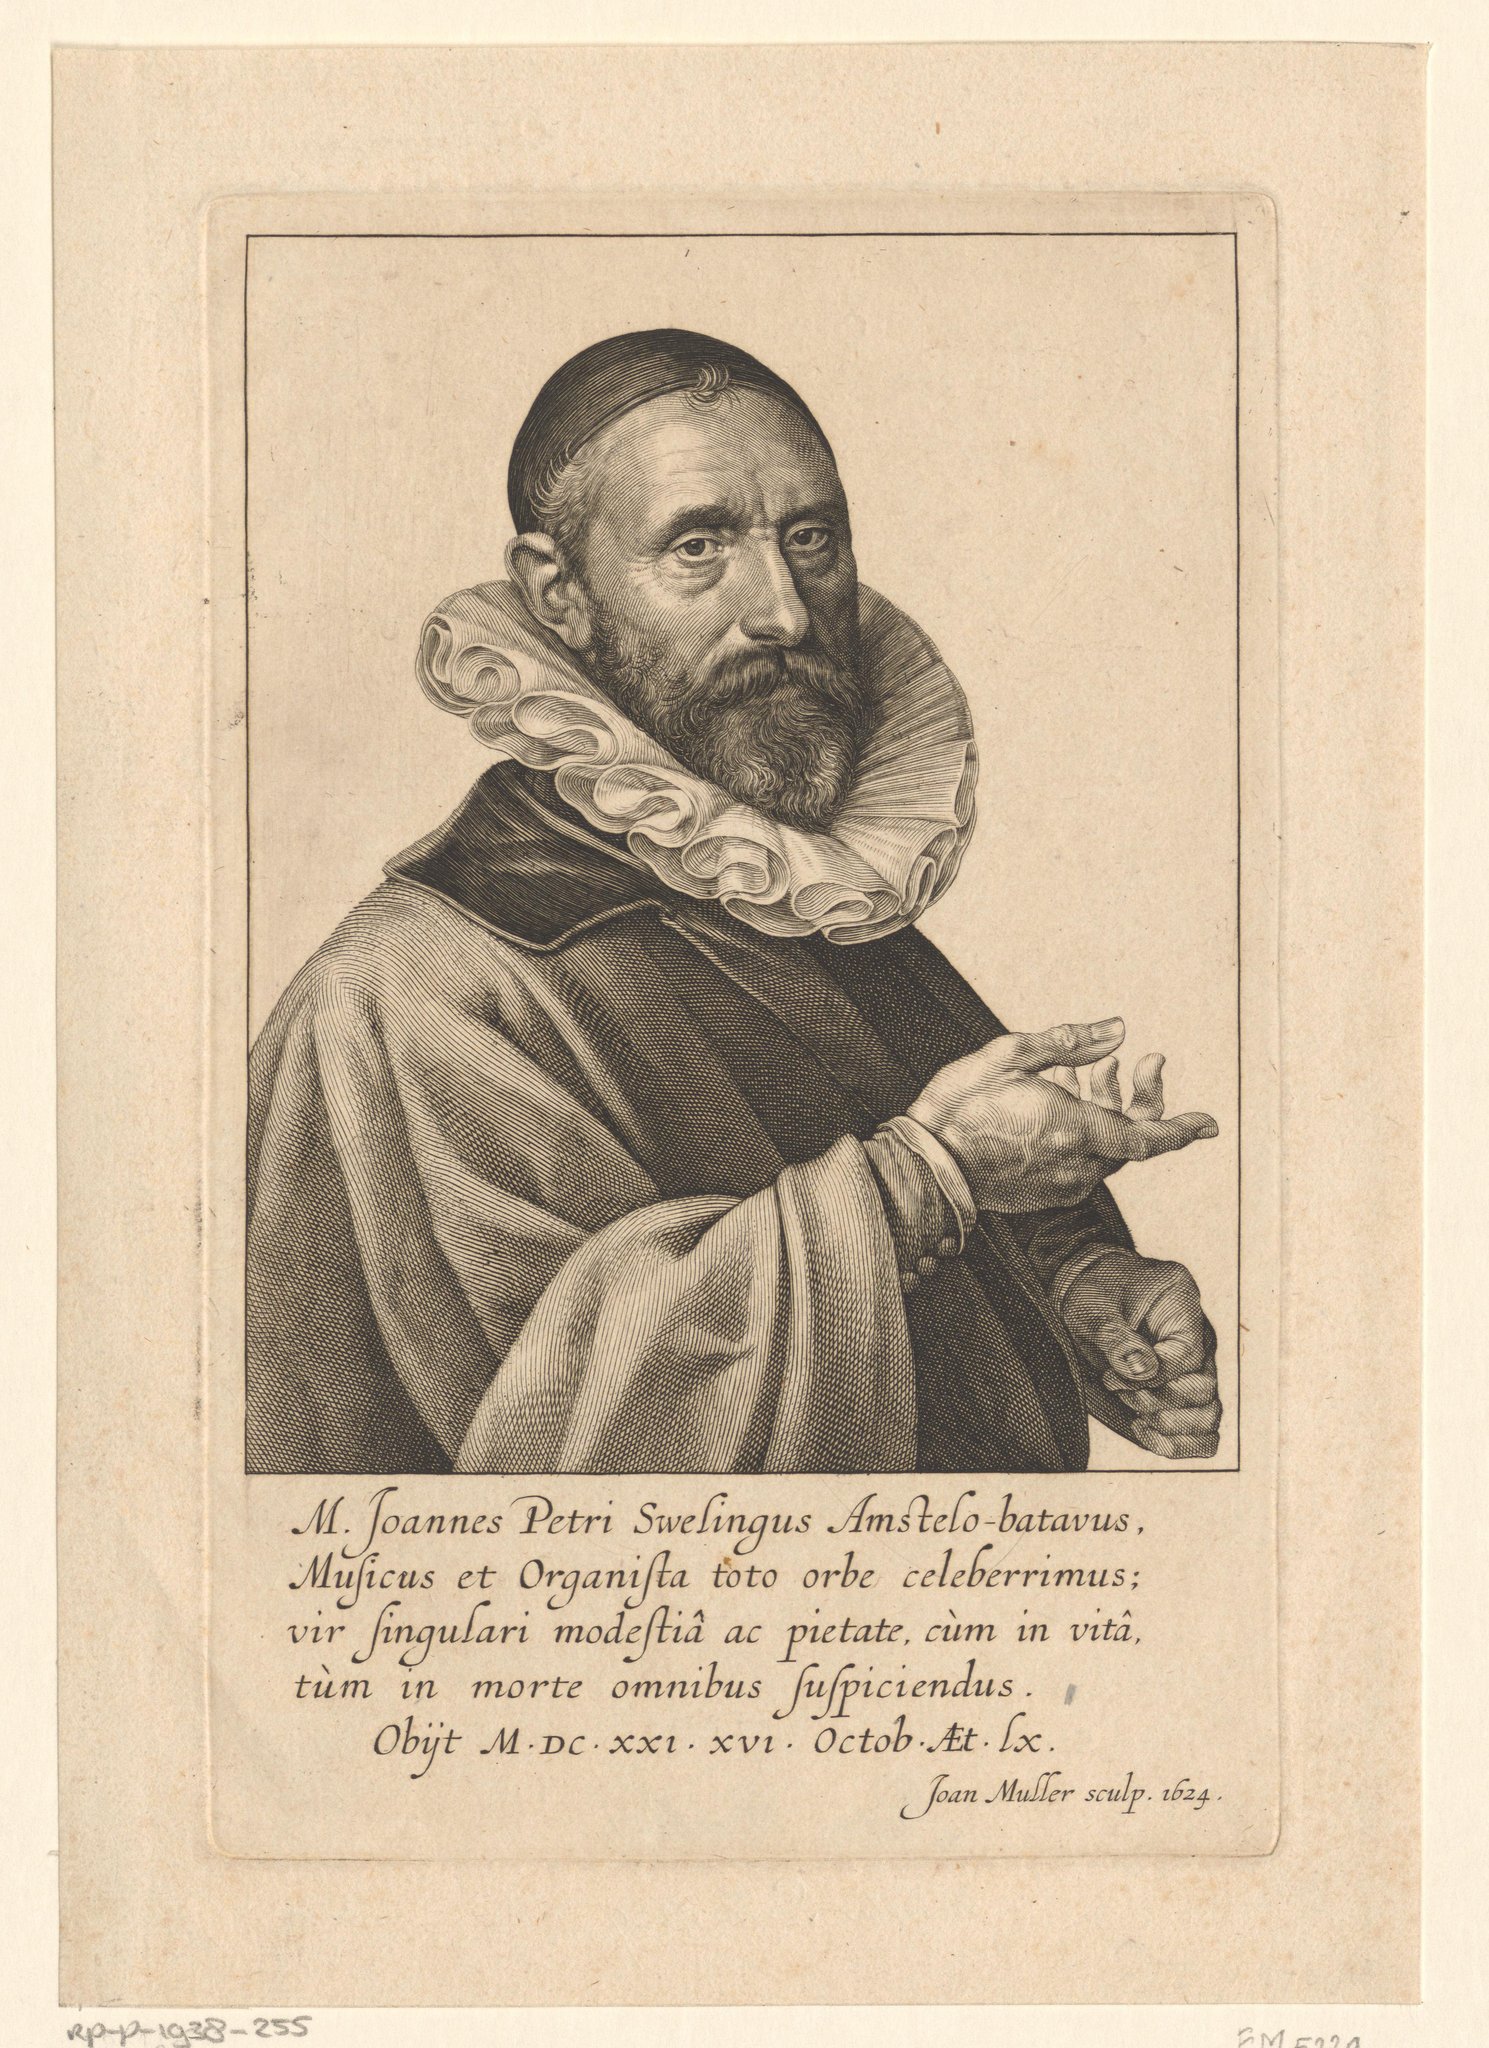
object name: print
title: Portret van Jan Pieterszoon Sweelinck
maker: jan harmensz. muller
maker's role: draughtsman, print maker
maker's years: 1571-1628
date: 1624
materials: paper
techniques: engraving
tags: deventer, amsterdam, historical persons, portrait of a musician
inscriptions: collector's mark: Lugt 2760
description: Onder het portret een vijfregelig onderschrift in het Latijn.